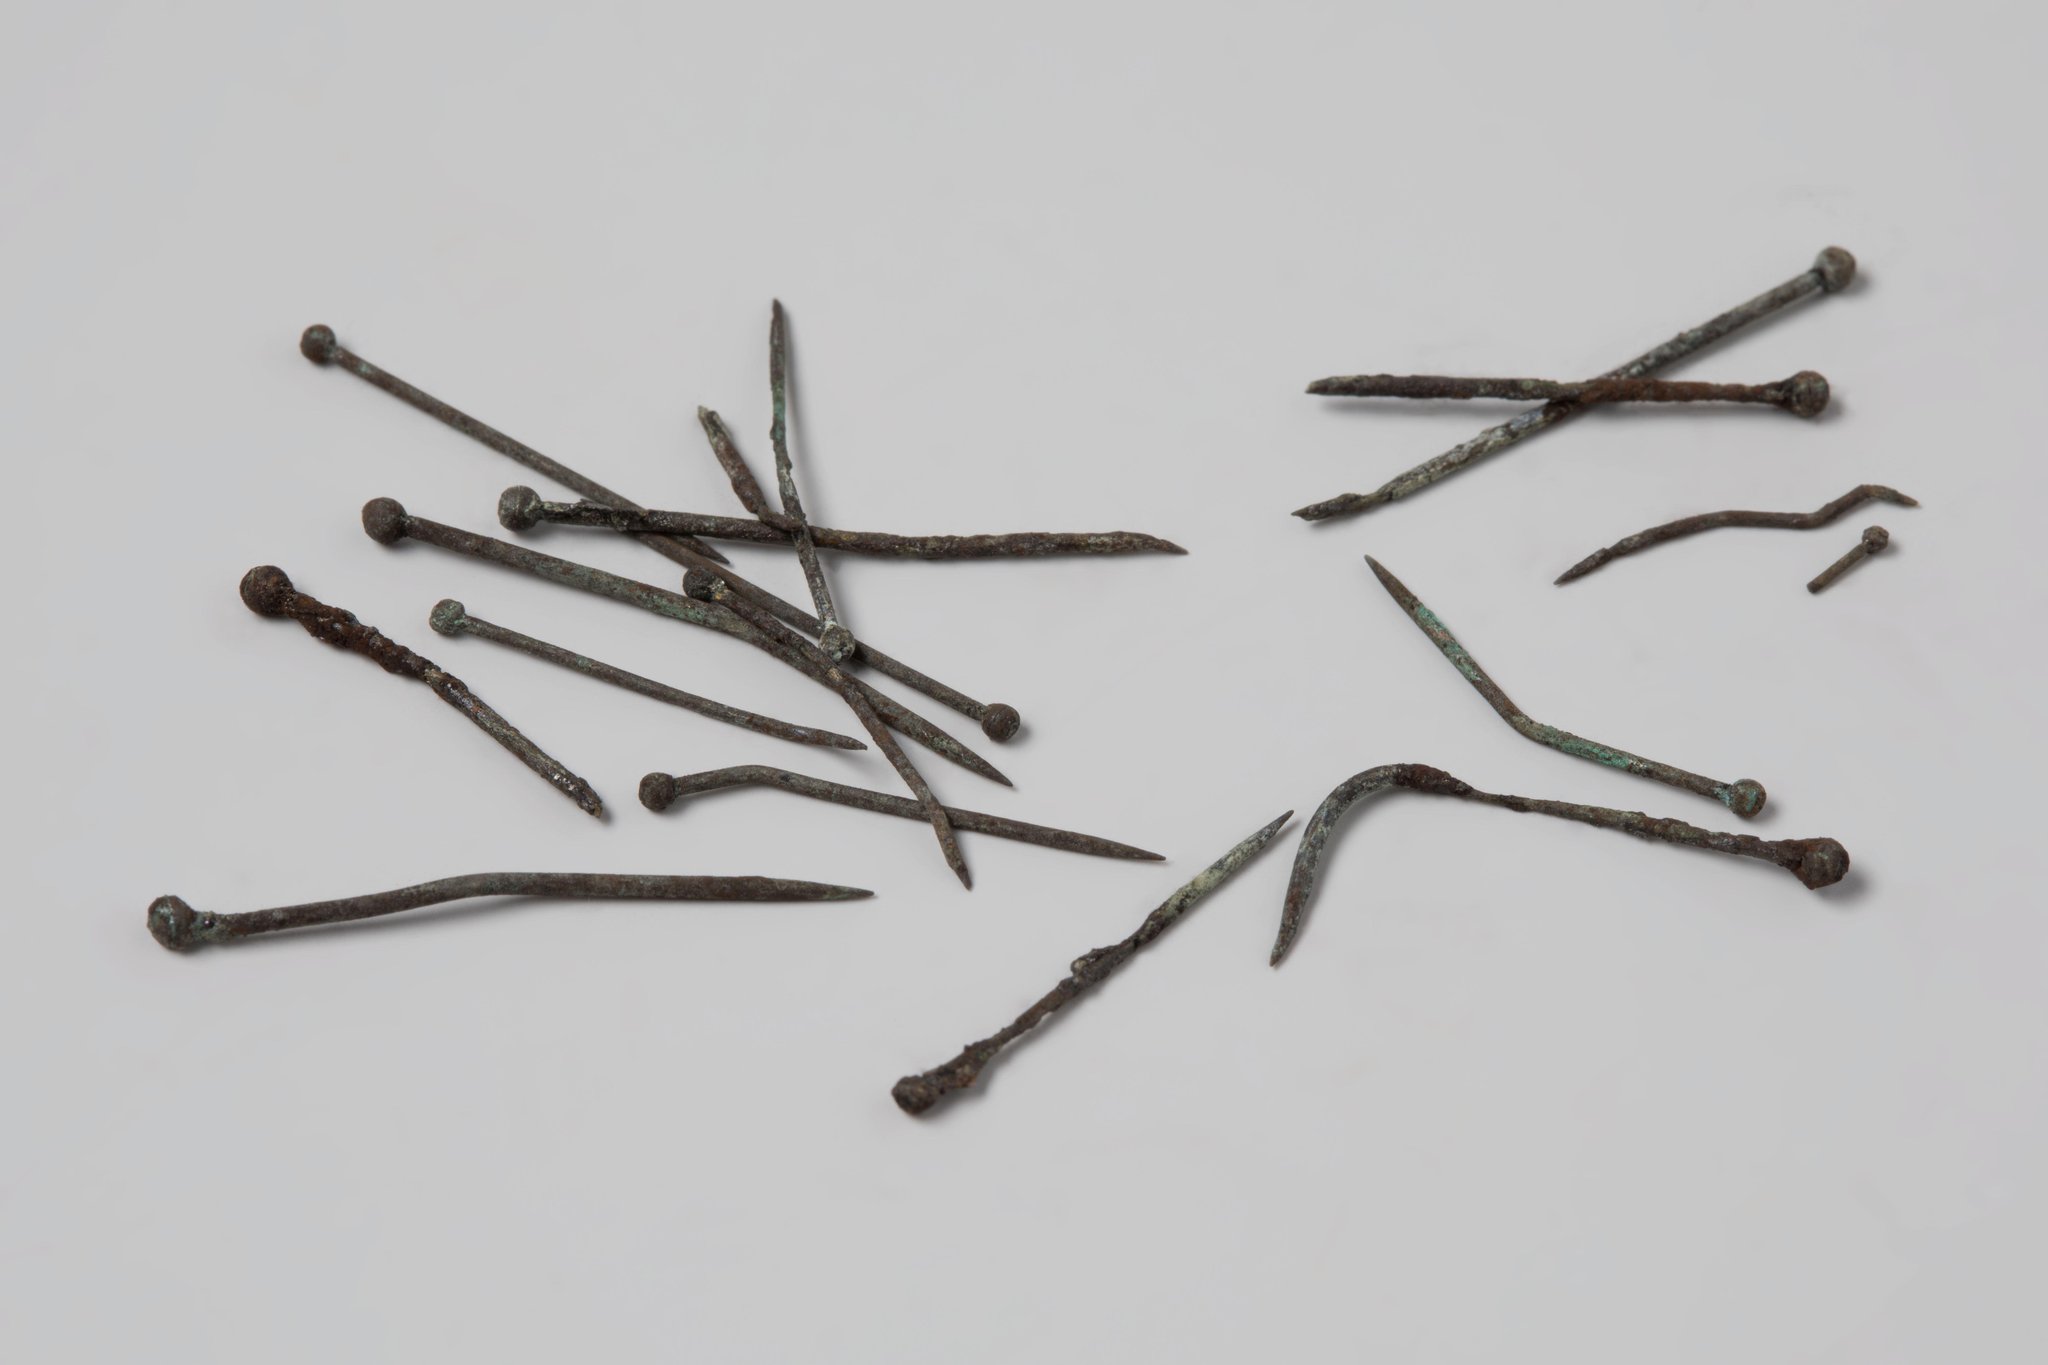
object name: pin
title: Spelden uit het wrak van de Oost-Indiëvaarder Hollandia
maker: Anonymous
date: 1700-1743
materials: copper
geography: netherlands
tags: verenigde oostindische compagnie, hollandia (schip), annet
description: Tools and instruments, sewing and sailmaking, pin; id. NG 1979-434H.